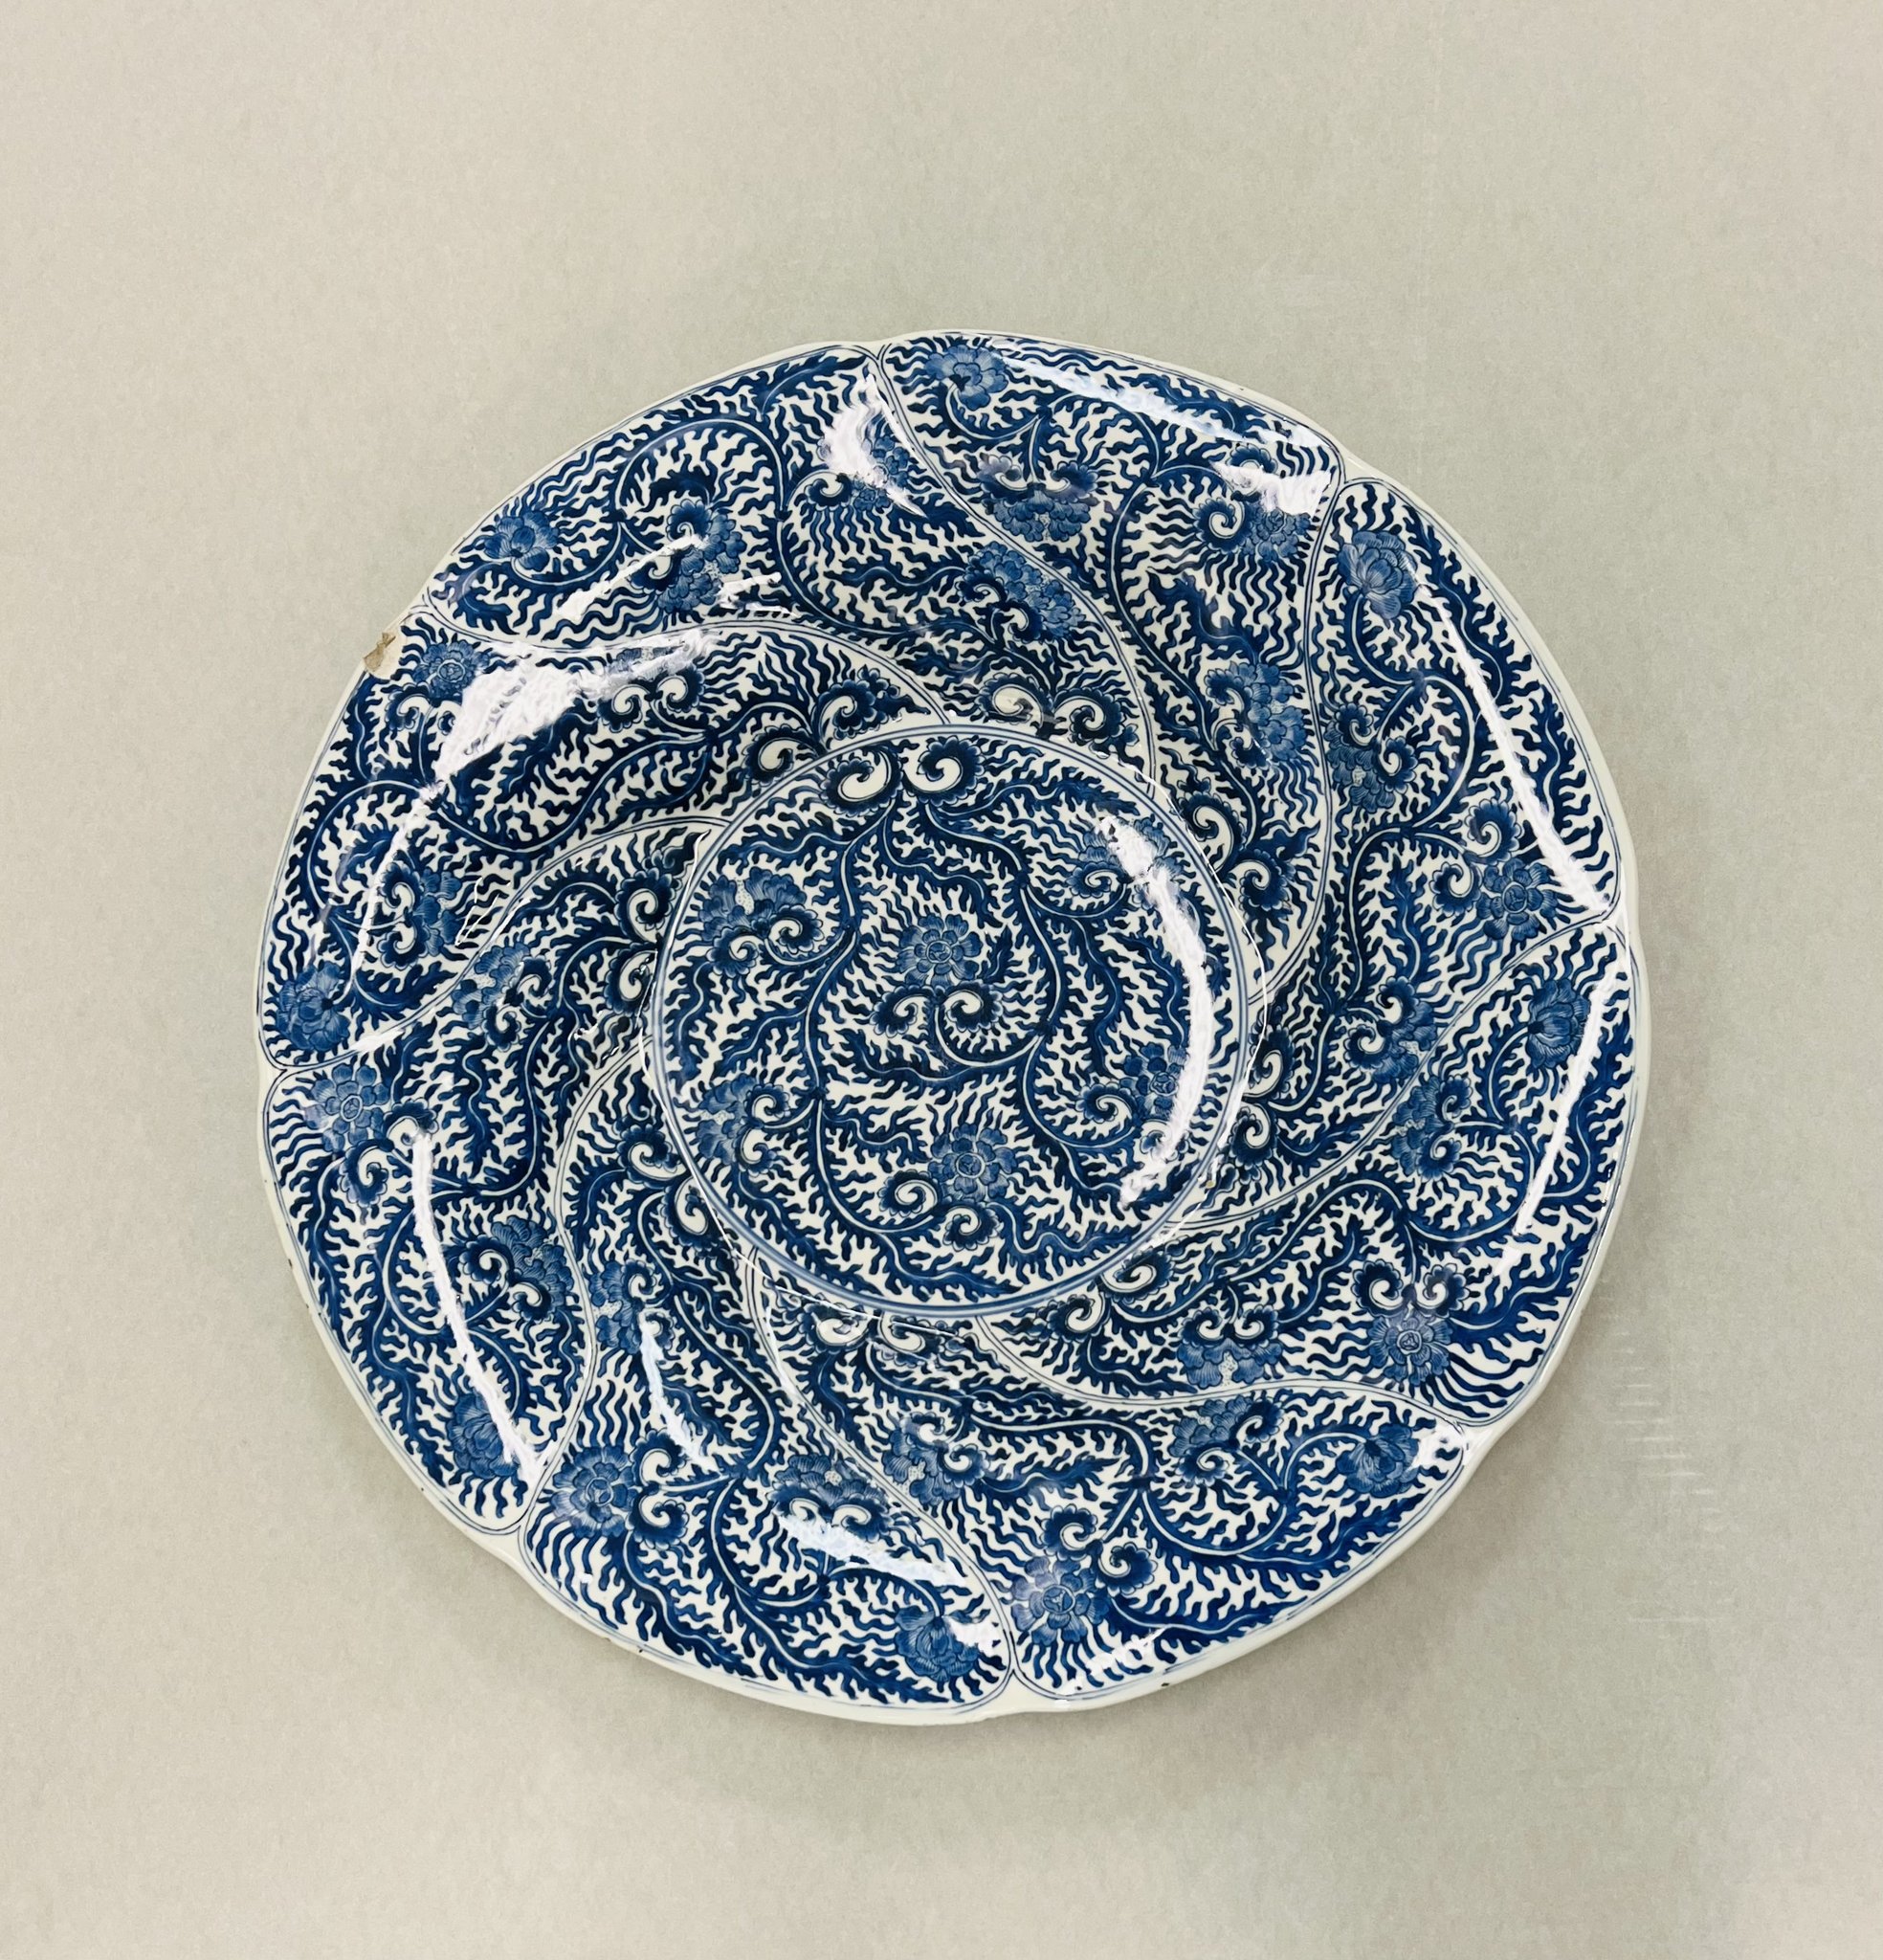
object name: plate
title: Plate with scalloped rim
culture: chinese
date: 1667-1733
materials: cobalt, porcelain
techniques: painting, underglaze